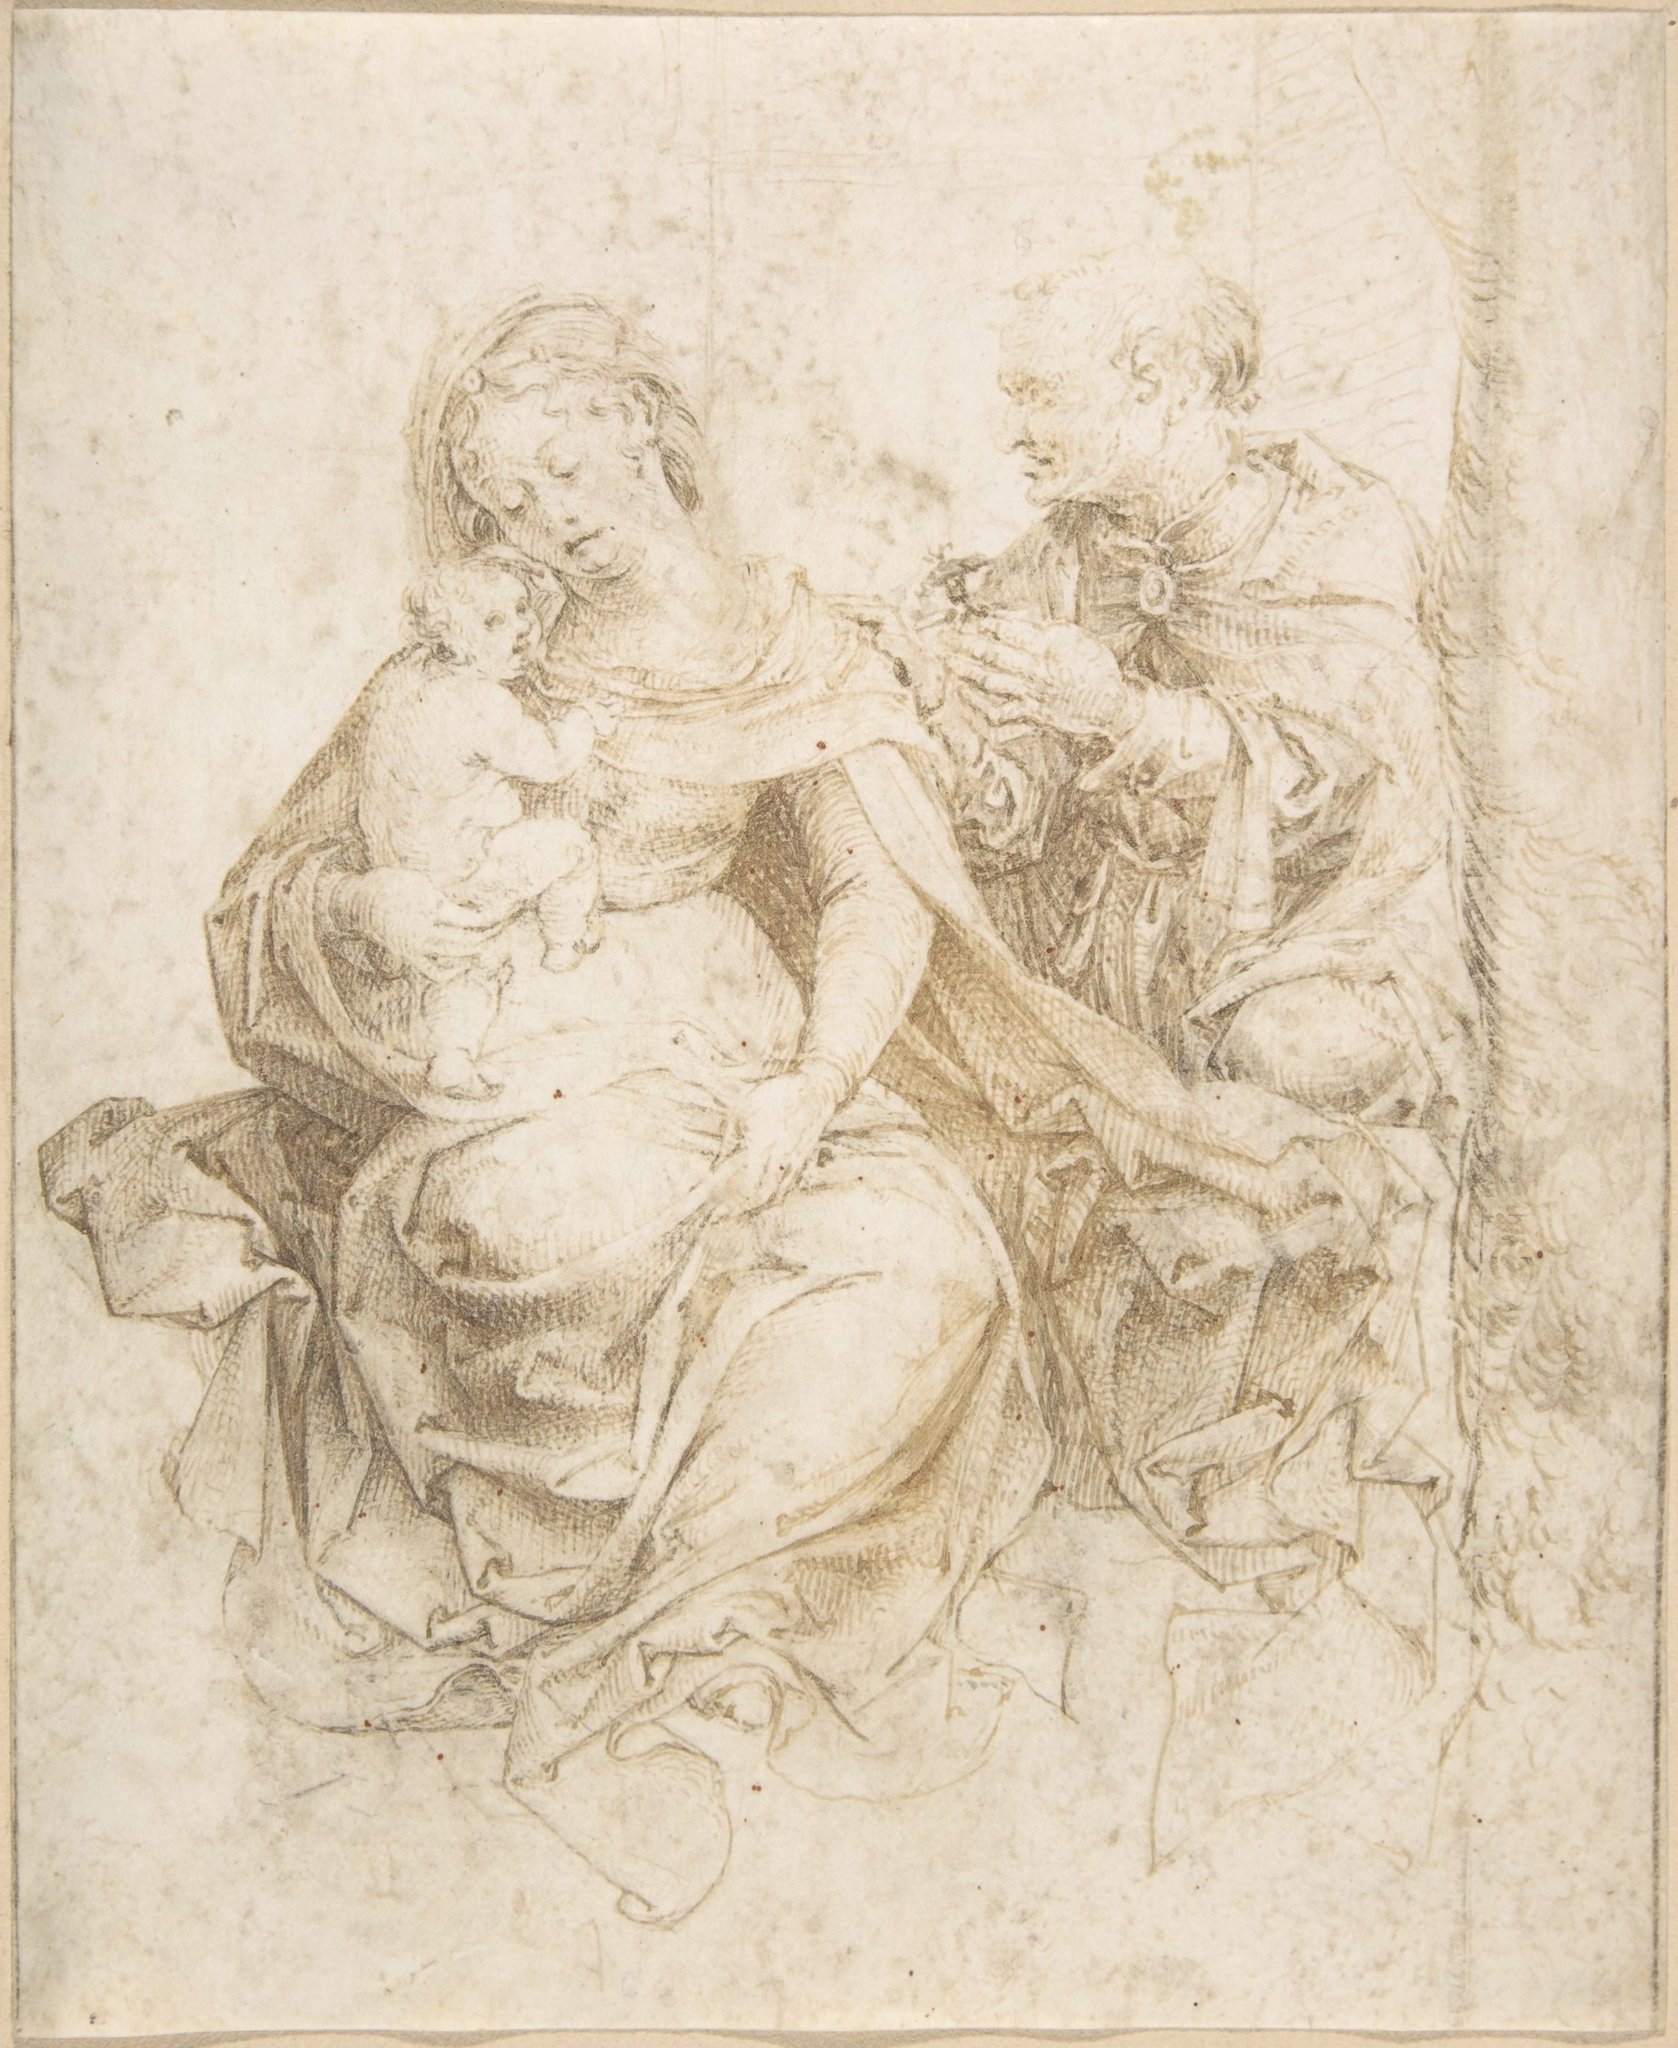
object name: drawing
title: The Holy Family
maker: jan gossart (called mabuse)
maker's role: artist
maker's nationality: netherlandish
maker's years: 1478-1532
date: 1510-1520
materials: chalk, ink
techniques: pen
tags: holy family,virgin mary,jesus,joseph